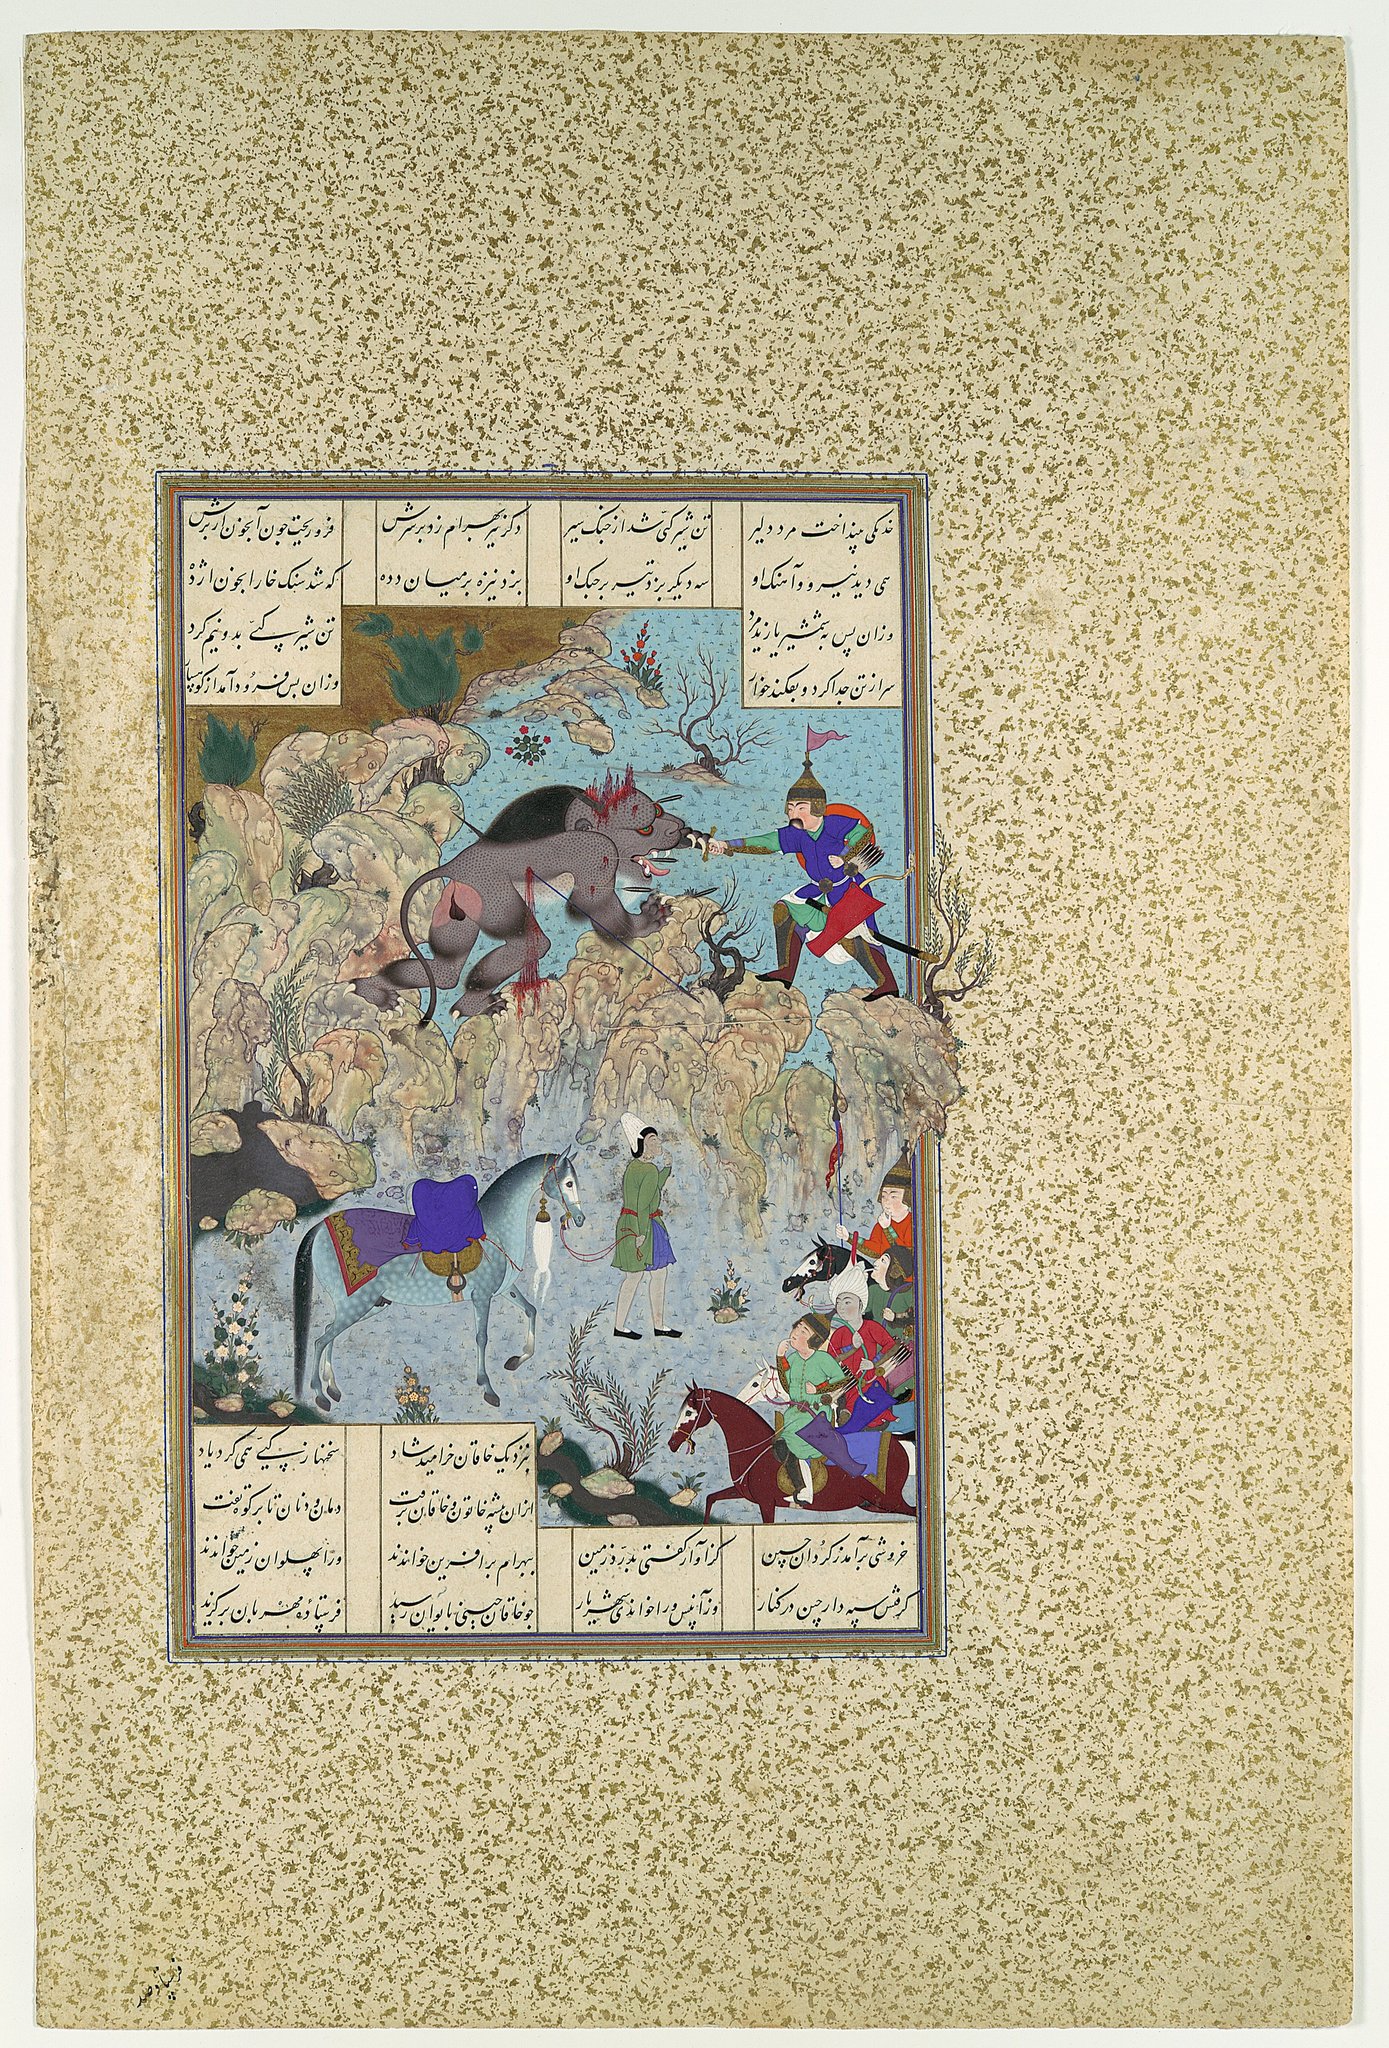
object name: folio from an illustrated manuscript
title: "Bahram Chubina Slays the Lion-Ape", Folio 715v from the Shahnama (Book of Kings) of Shah Tahmasp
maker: abu'l qasim firdausi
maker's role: author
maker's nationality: iranian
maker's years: 935-1020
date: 1530-1535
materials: gold, ink, paper, silver, watercolor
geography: iran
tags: kings,men,horses